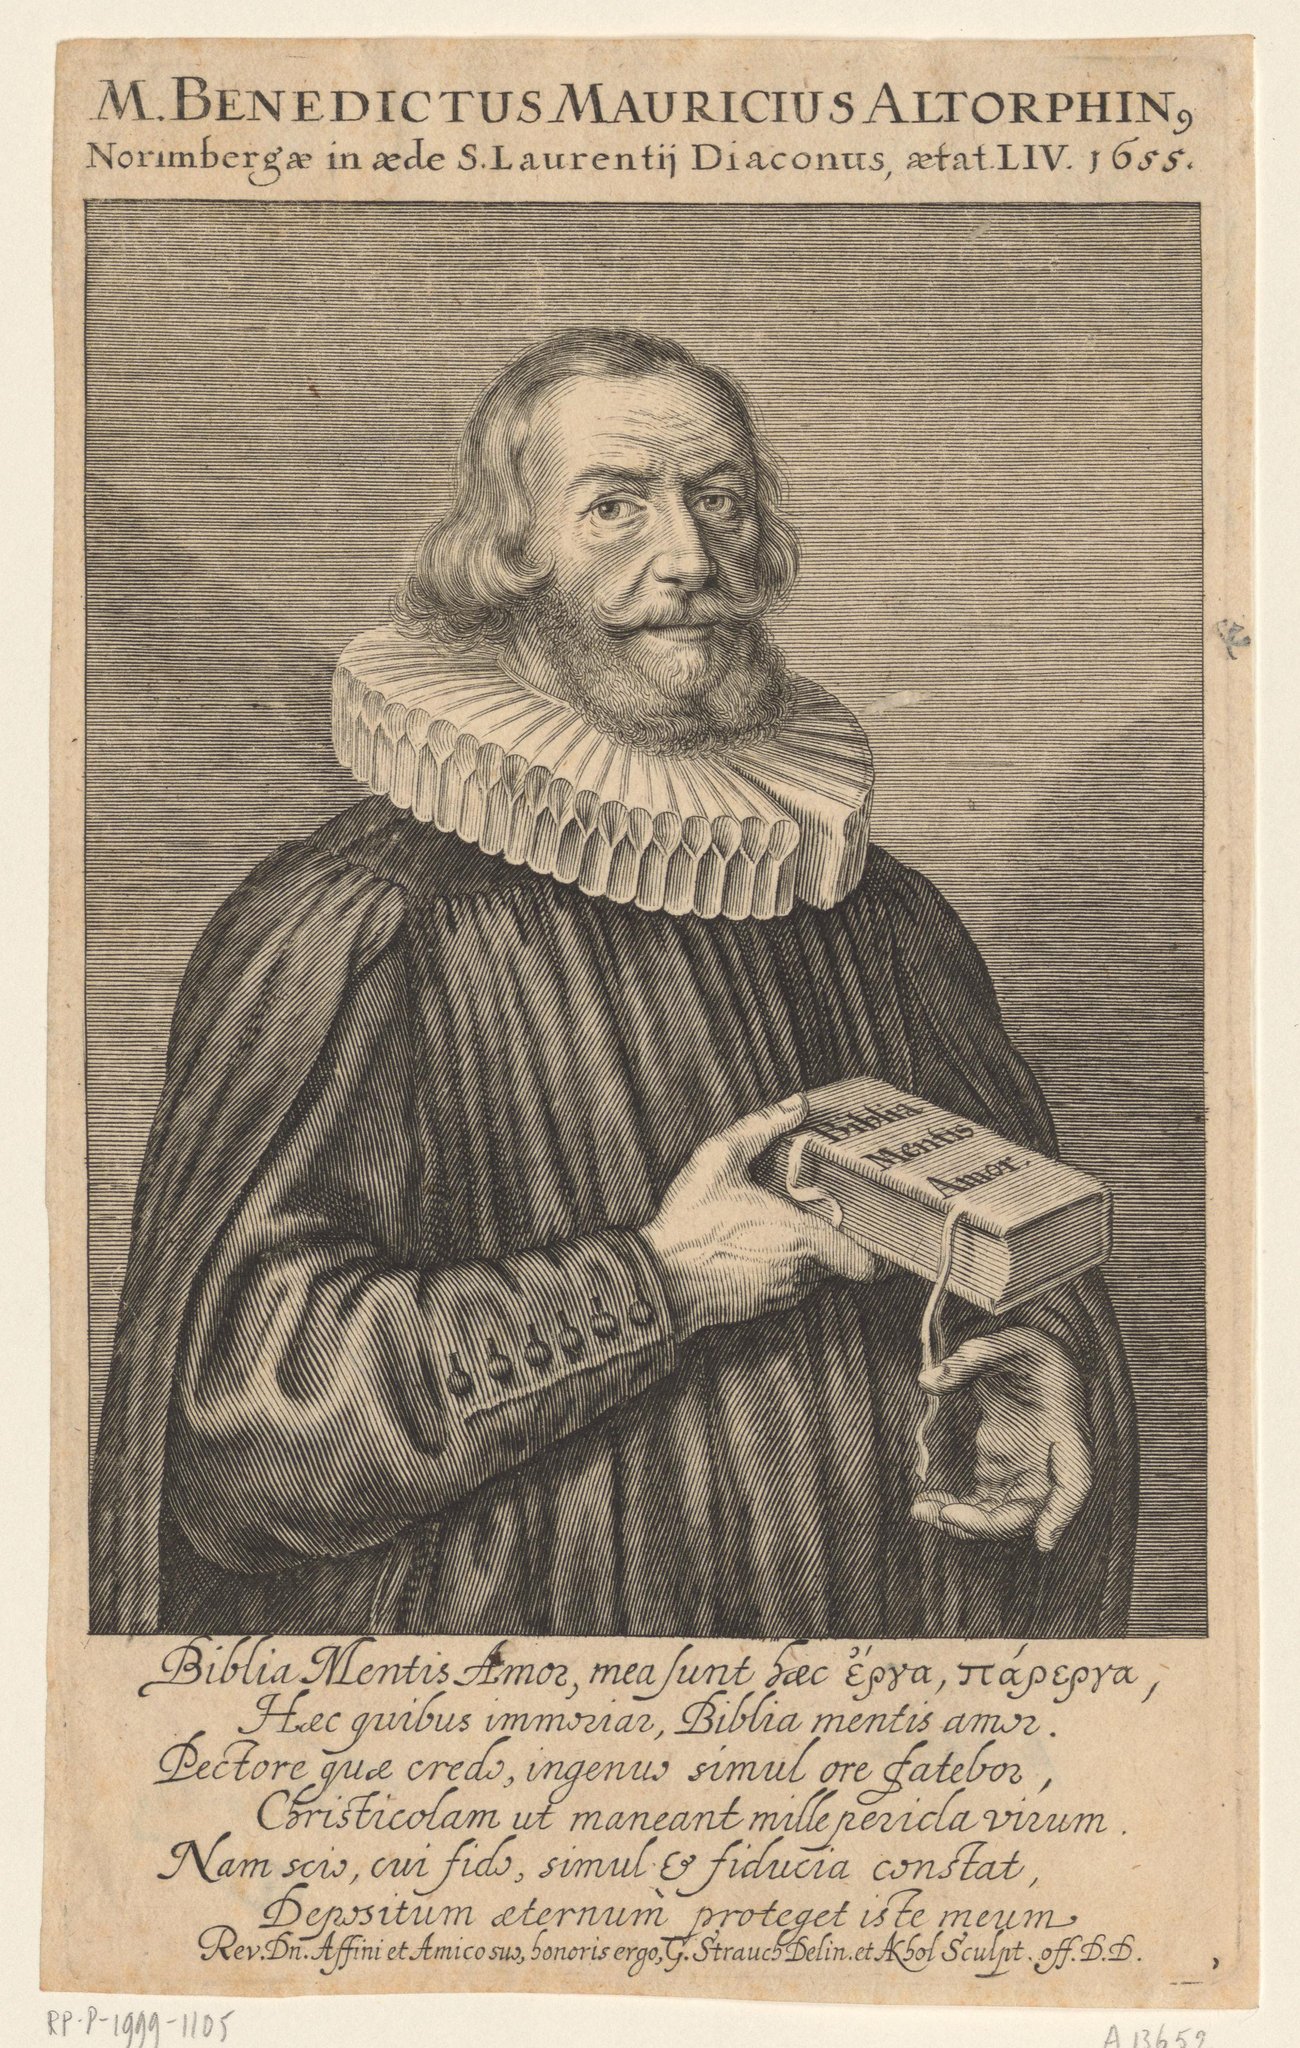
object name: print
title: Portret van Benedict Mauricius op 54-jarige leeftijd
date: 1655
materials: paper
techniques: engraving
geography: germany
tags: benedict mauricius, theologian, historical persons, the bible as a book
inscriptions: collector's mark: Lugt 2228, collector's mark: Lugt 2481a, number: ‘55670.’, number: ‘17’, inscription: ‘Th[...]ty’, collector's mark: Lugt 1614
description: Met zesregelig onderschrift in het Latijn.